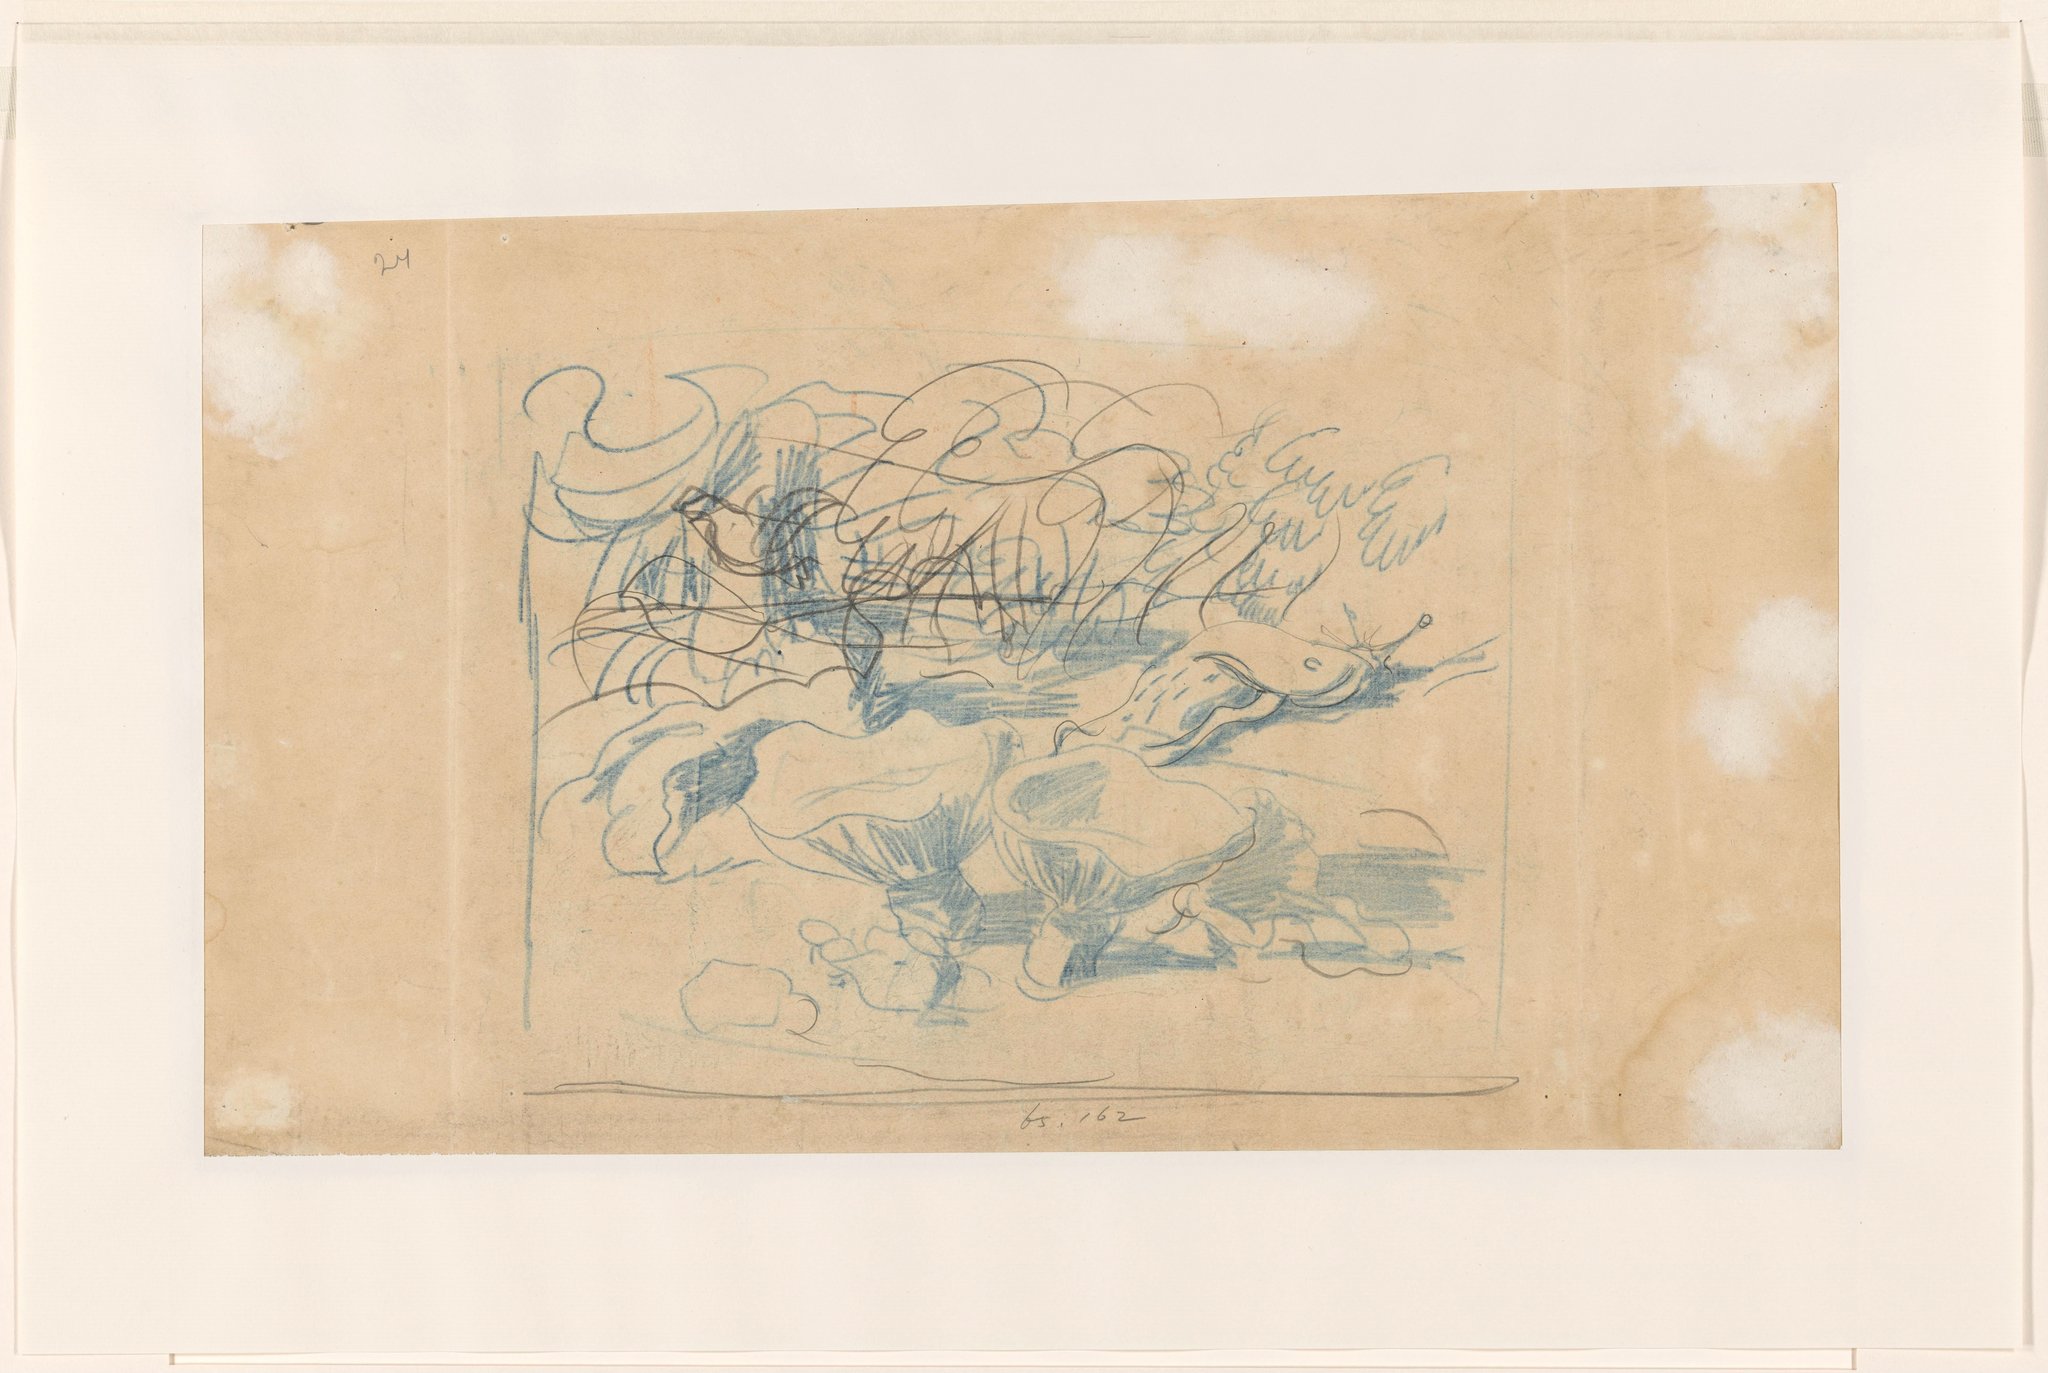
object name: drawing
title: Schets van paddestoelen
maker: willem van konijnenburg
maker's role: draughtsman, painter, print maker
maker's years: 1868-1943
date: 1878-1943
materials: paper, pencil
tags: mushrooms